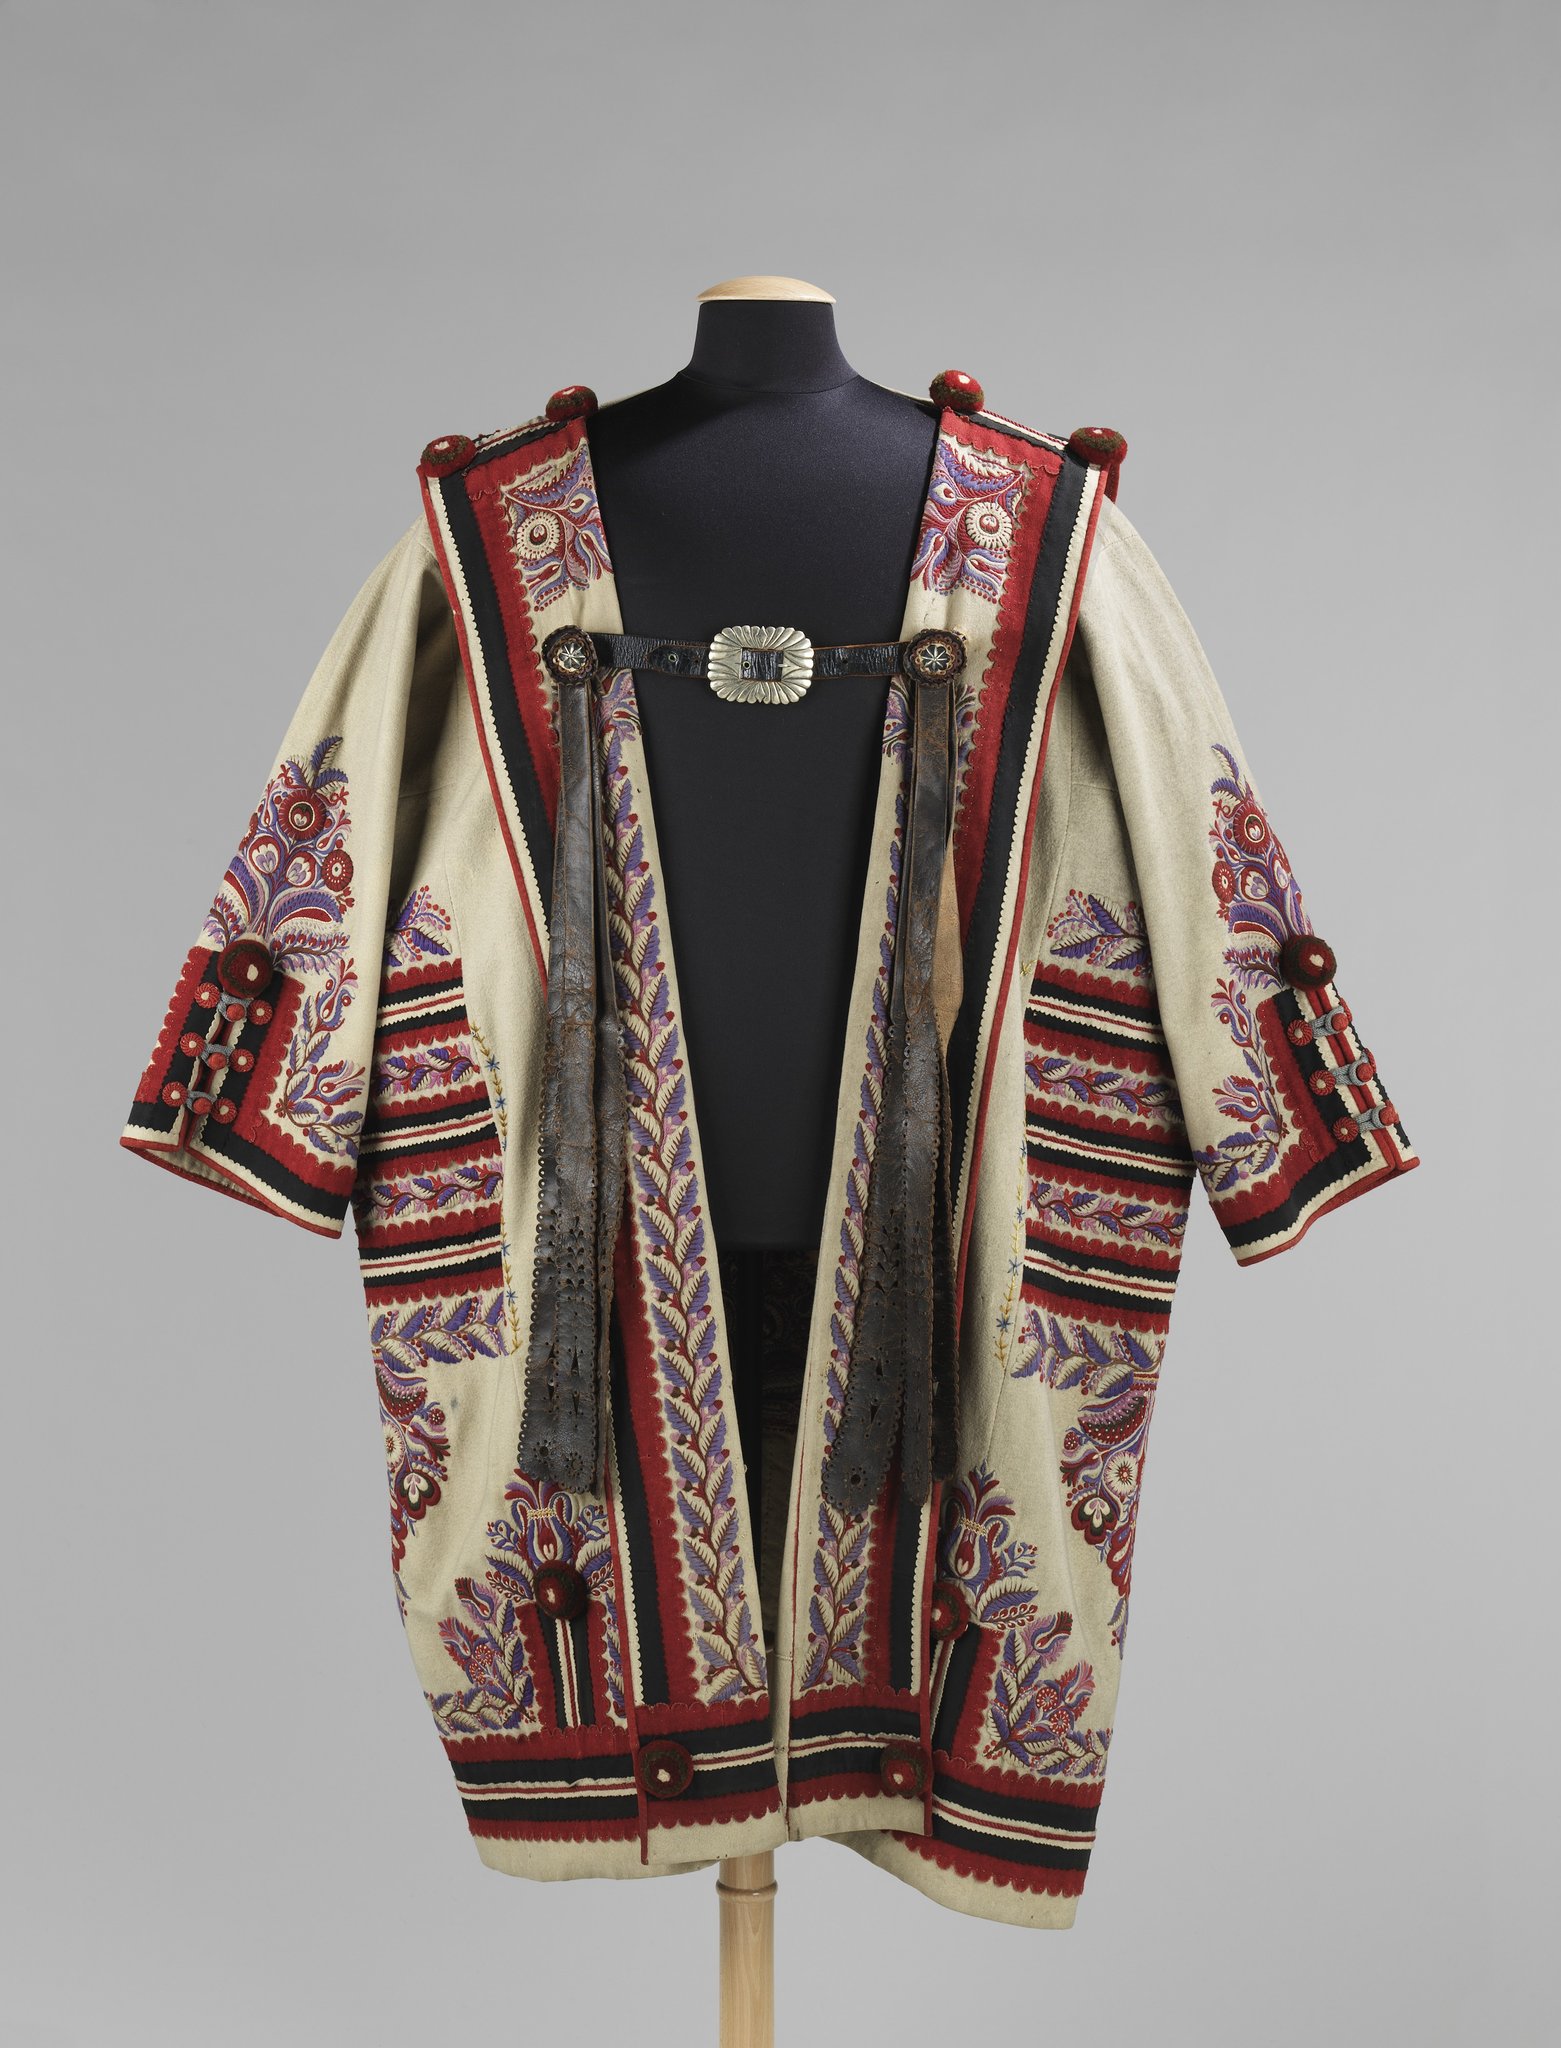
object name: mantle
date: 1867-1900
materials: leather, metal, wool